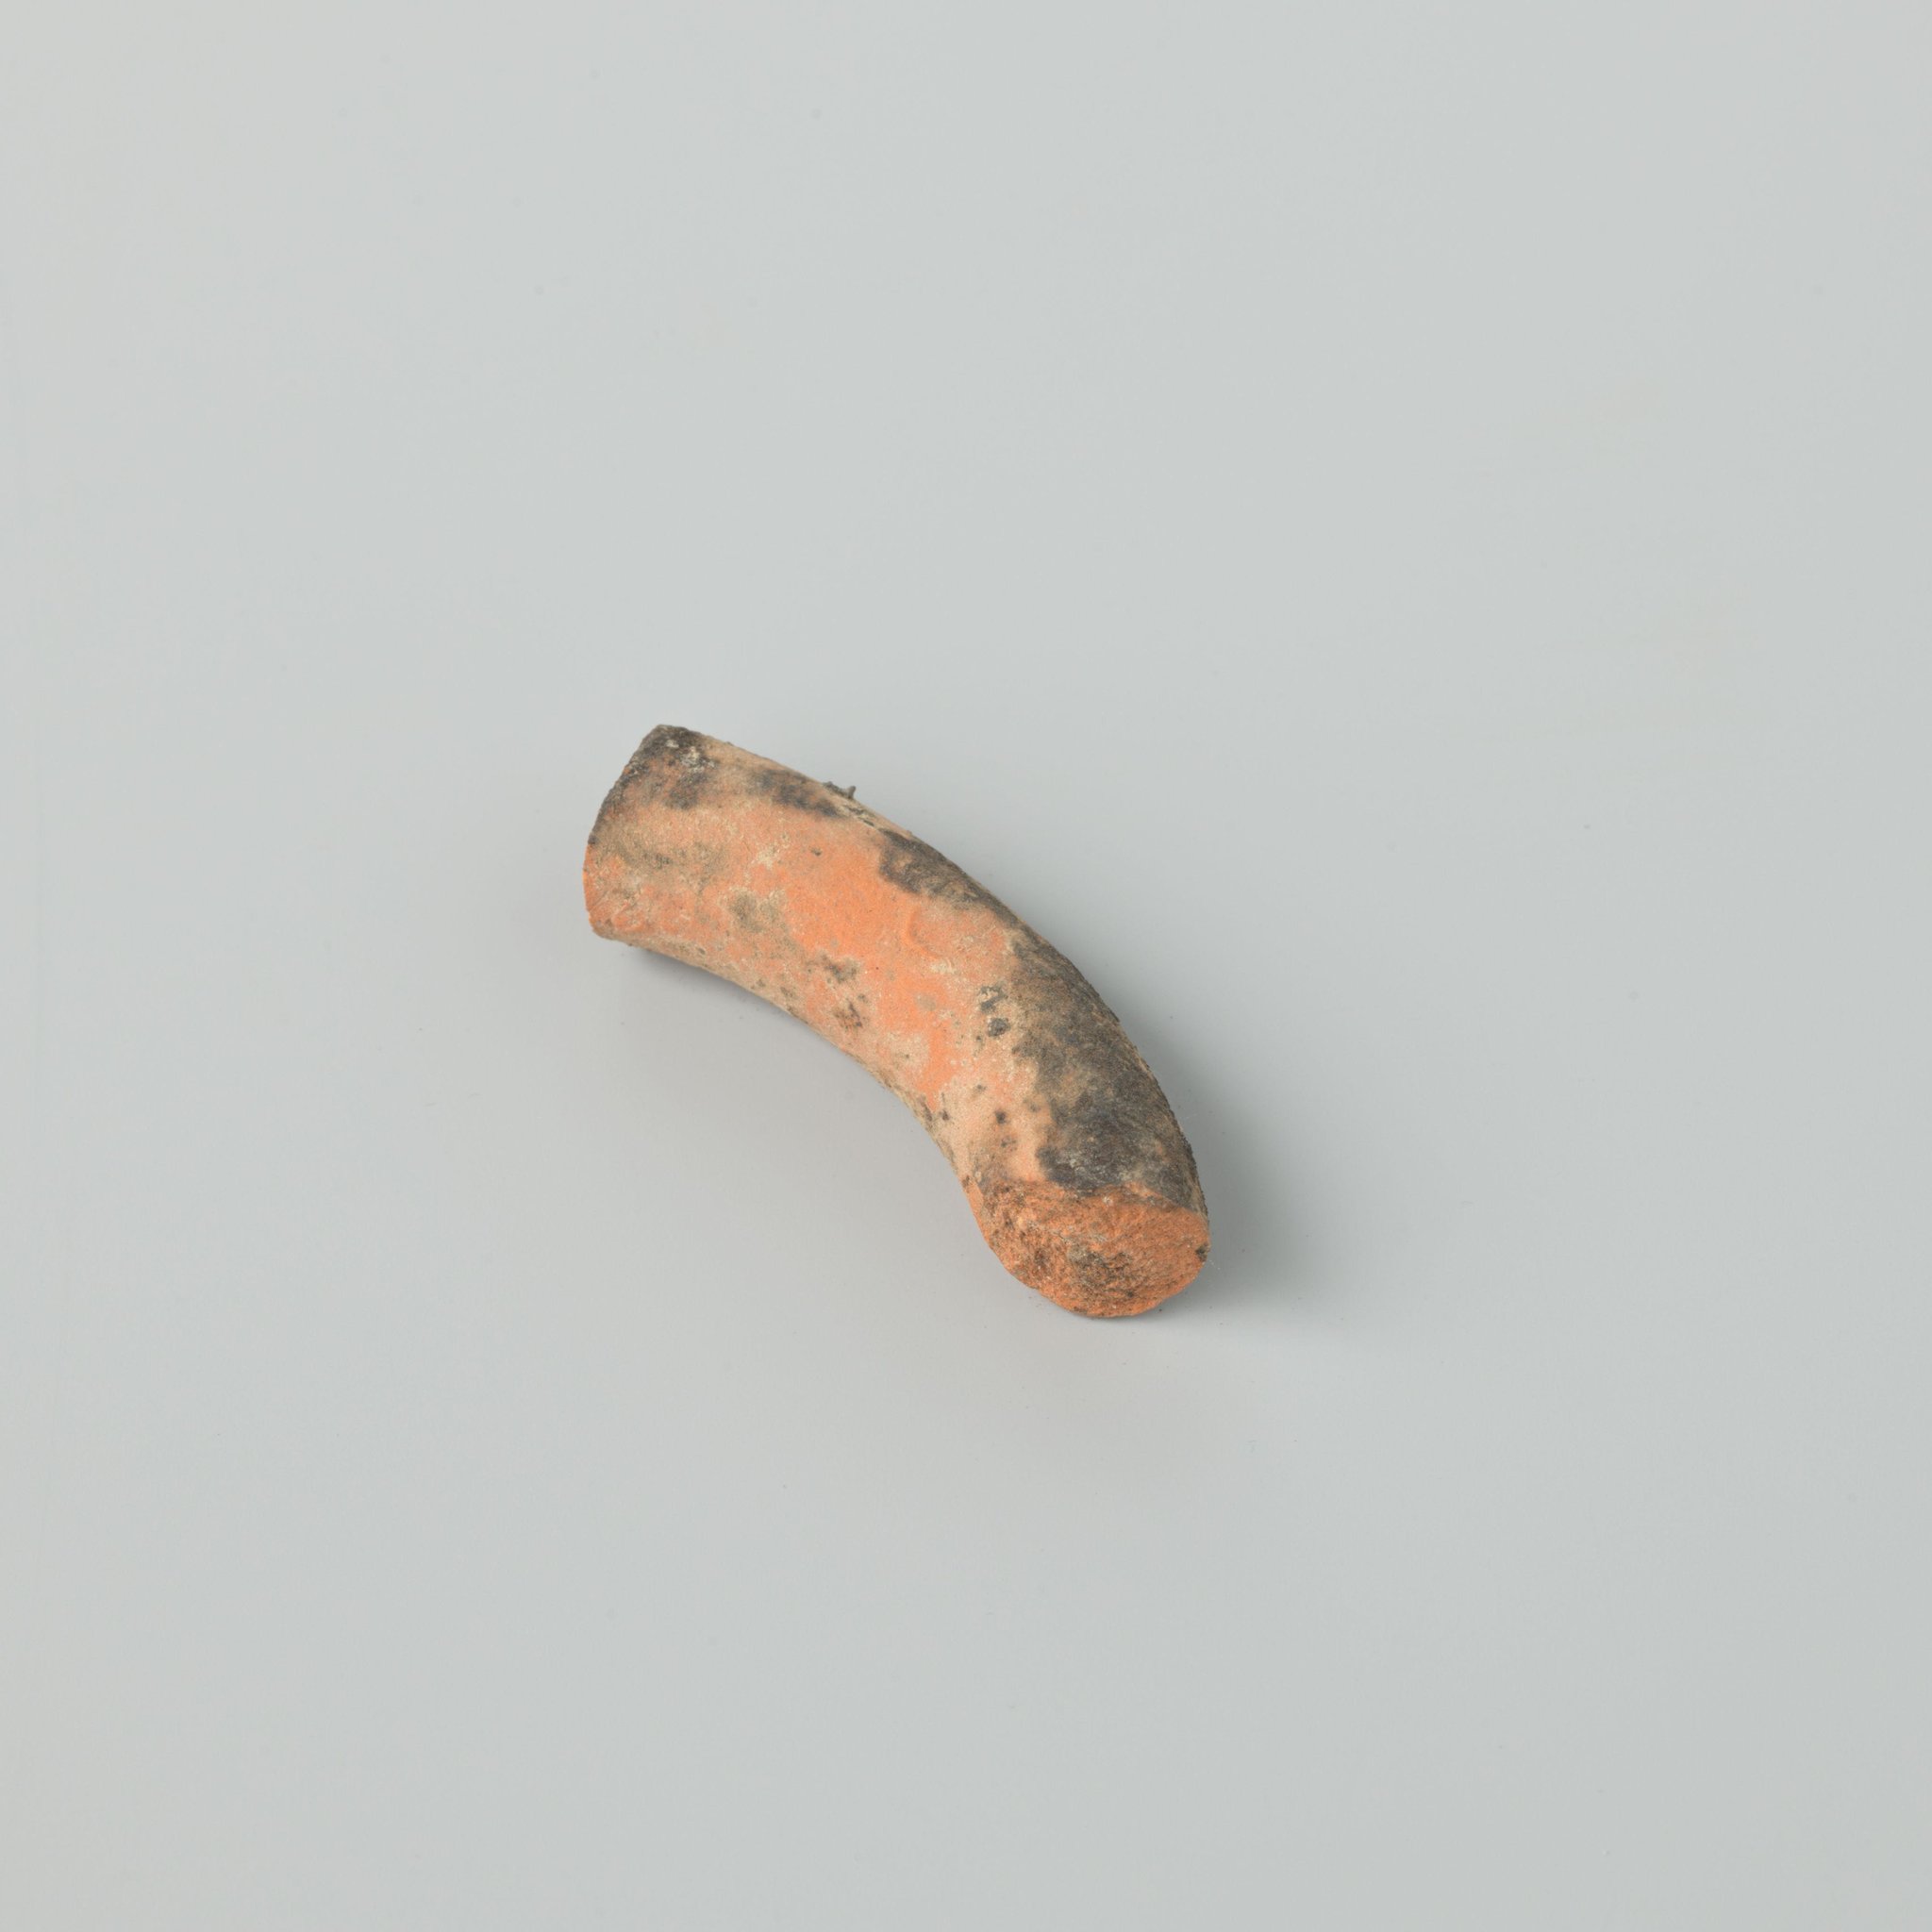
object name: sherd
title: Fragment van een oor van een theepot (De Caluwe bakafval)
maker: jacobus de caluwe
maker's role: plateelbakkerij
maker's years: -1730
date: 1700-1725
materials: earthenware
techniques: firing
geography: delft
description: Toegeschreven aan Jacobus de Caluwe, omdat dit voorwerp samen met gemerkte stukken (‘Jacobus De Caluwe’ en rennend hert) gevonden is op de plaats waar zich De Caluwes tweede werkplaats bevond. Er is een duidelijke stilistische overeenkomst tussen de gemerkte en niet gemerkte voorwerpen uit deze archeologische vondst.